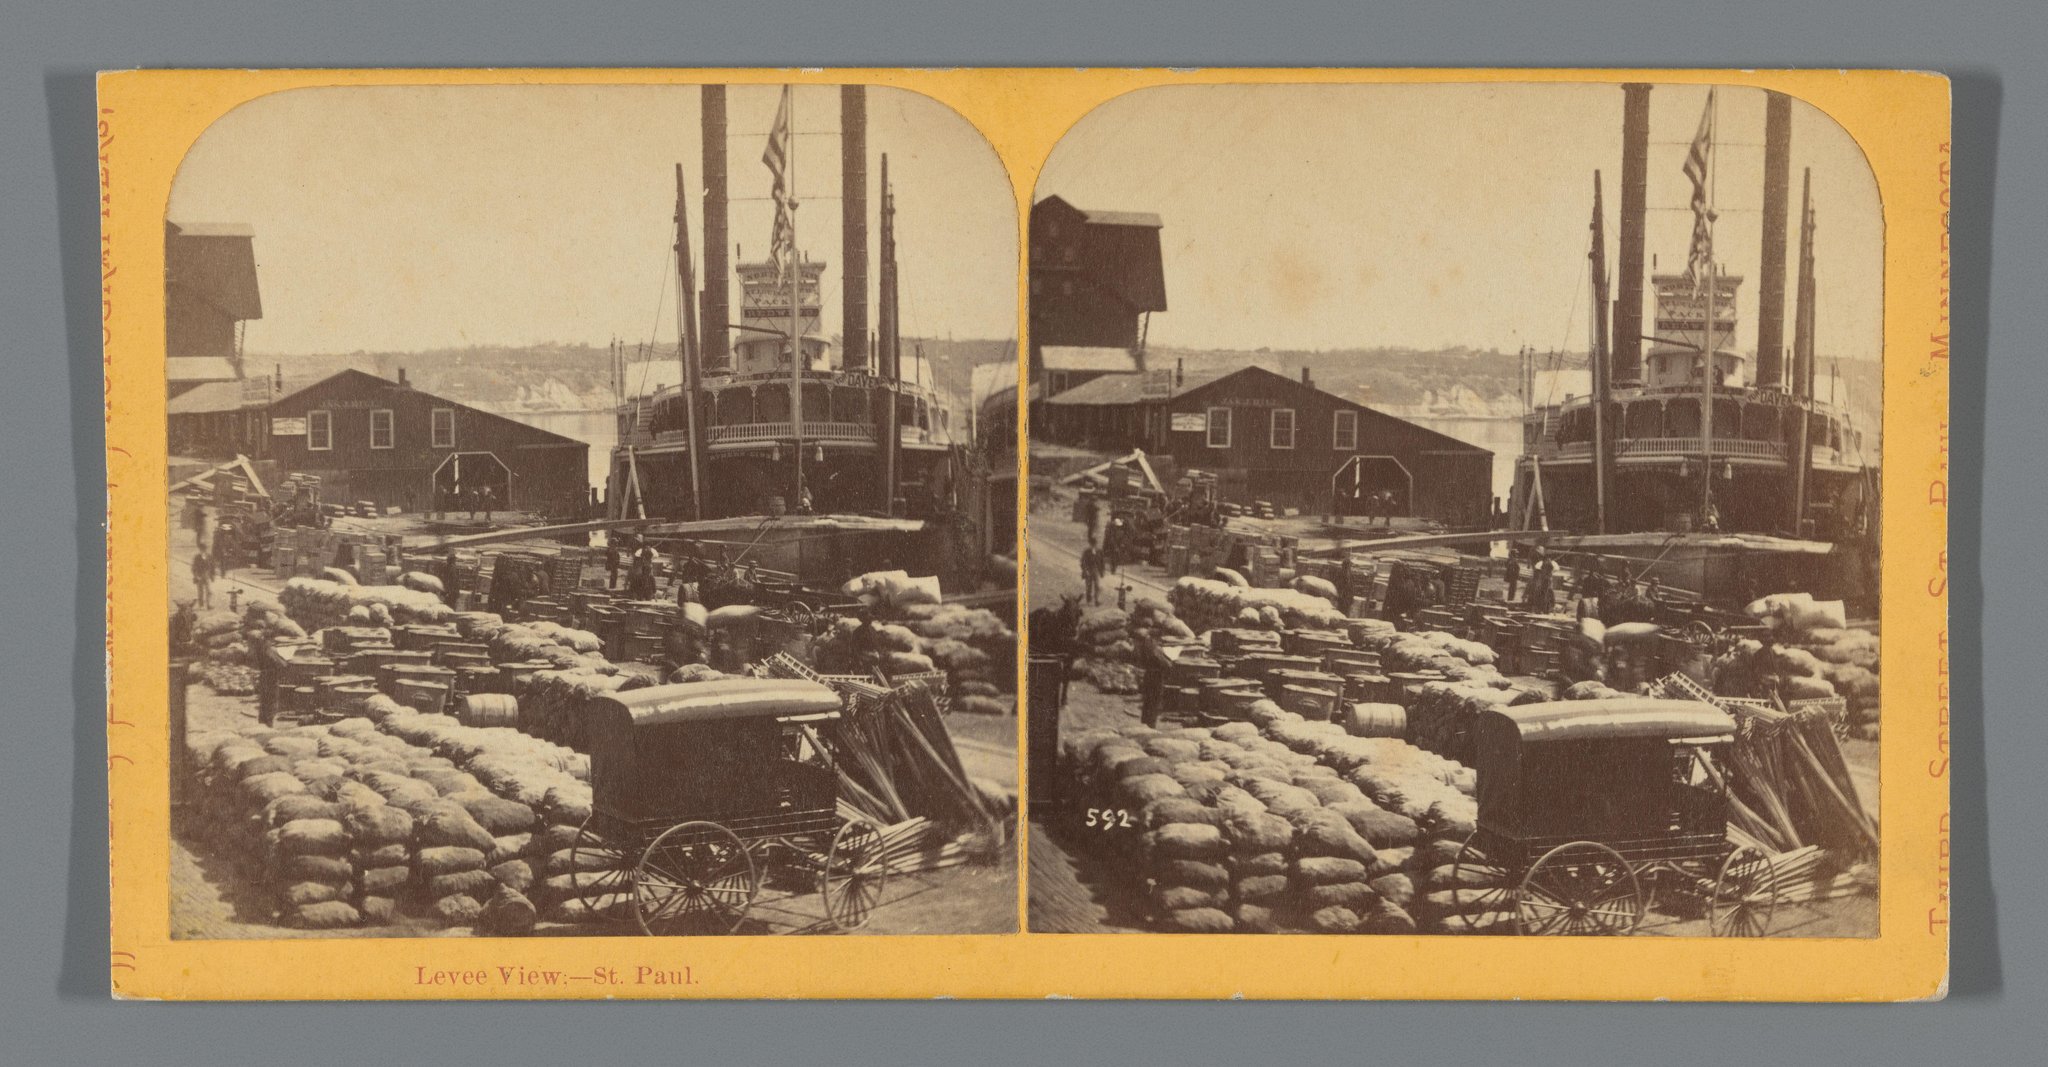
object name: photograph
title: Third Series, St. Paul, Minnesota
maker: charles a. zimmerman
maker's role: fotograaf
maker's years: 1844-1909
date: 1860-1909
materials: cardboard, photographic support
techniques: albumen print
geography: saint paul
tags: warehouse (~ harbour), freight vessel, container of textile material: bag, sack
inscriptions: number: ‘00147’, number: ‘292’